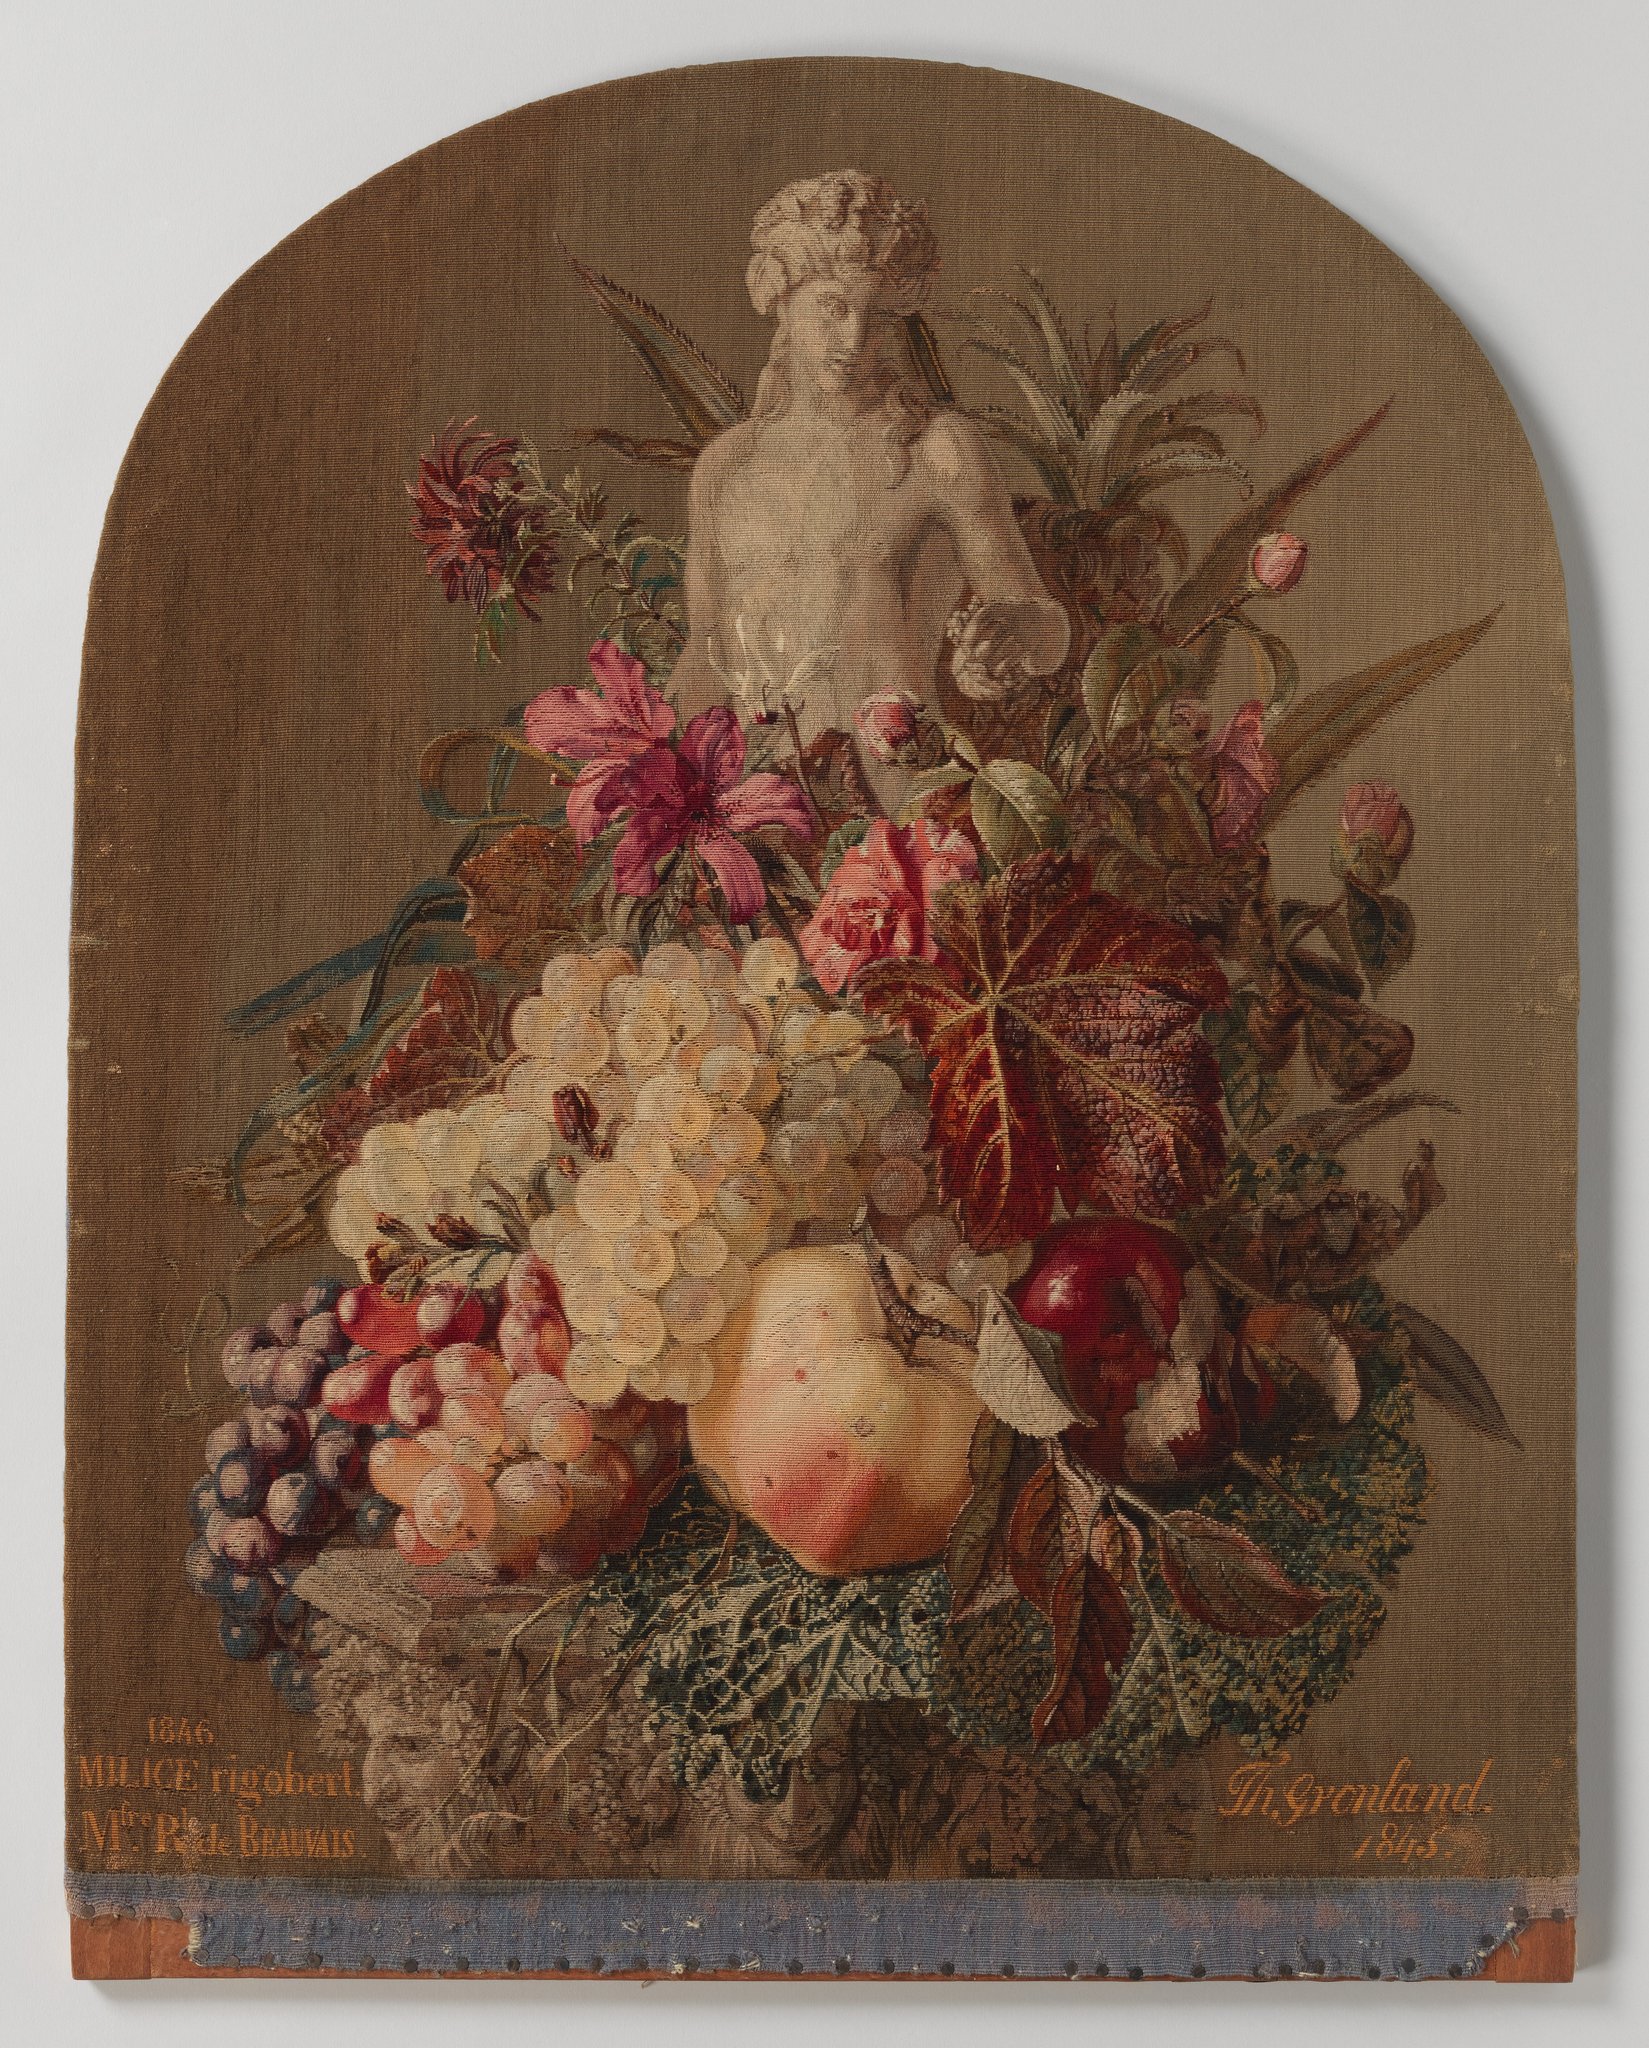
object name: tapestry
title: Still Life, Autumn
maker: theude grönland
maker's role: artist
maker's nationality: german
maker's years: 1817-1876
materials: silk, wool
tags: fruit,bacchus,flowers,still life